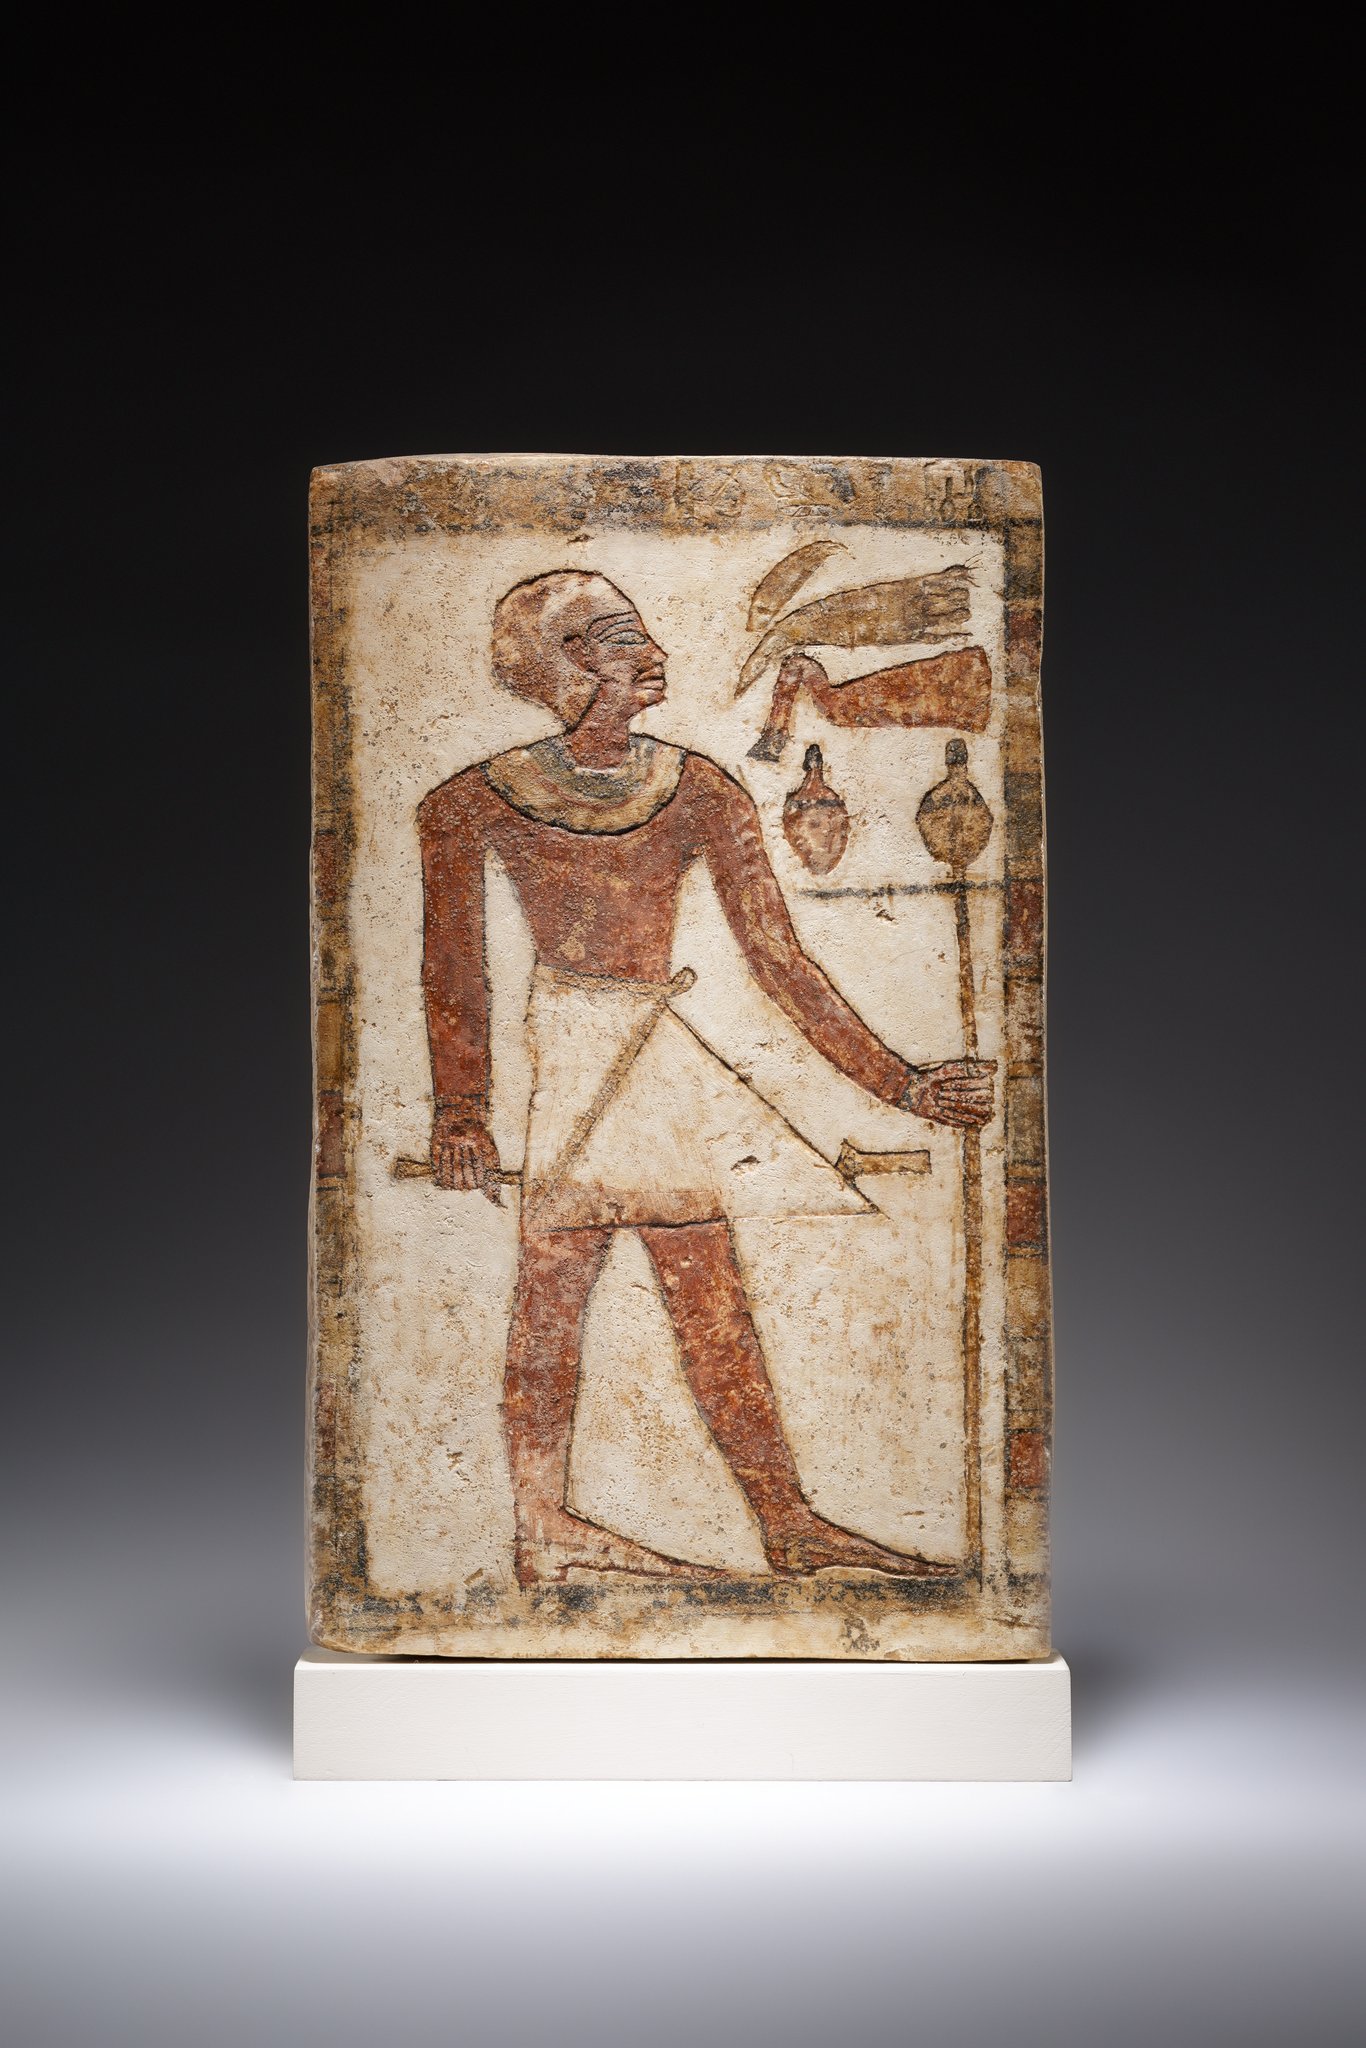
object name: stela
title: Stela of a Man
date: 2030-1981 BCE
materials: limestone, paint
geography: egypt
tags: men